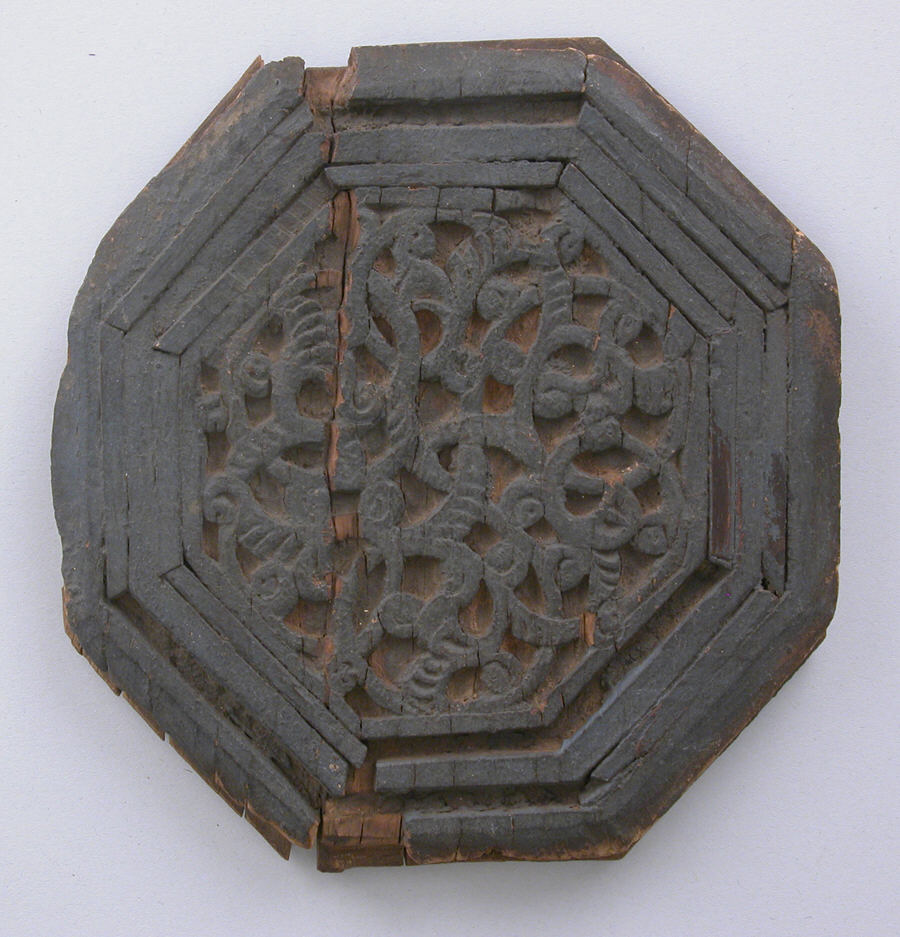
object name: panel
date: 1301-1500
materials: wood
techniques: carving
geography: egypt